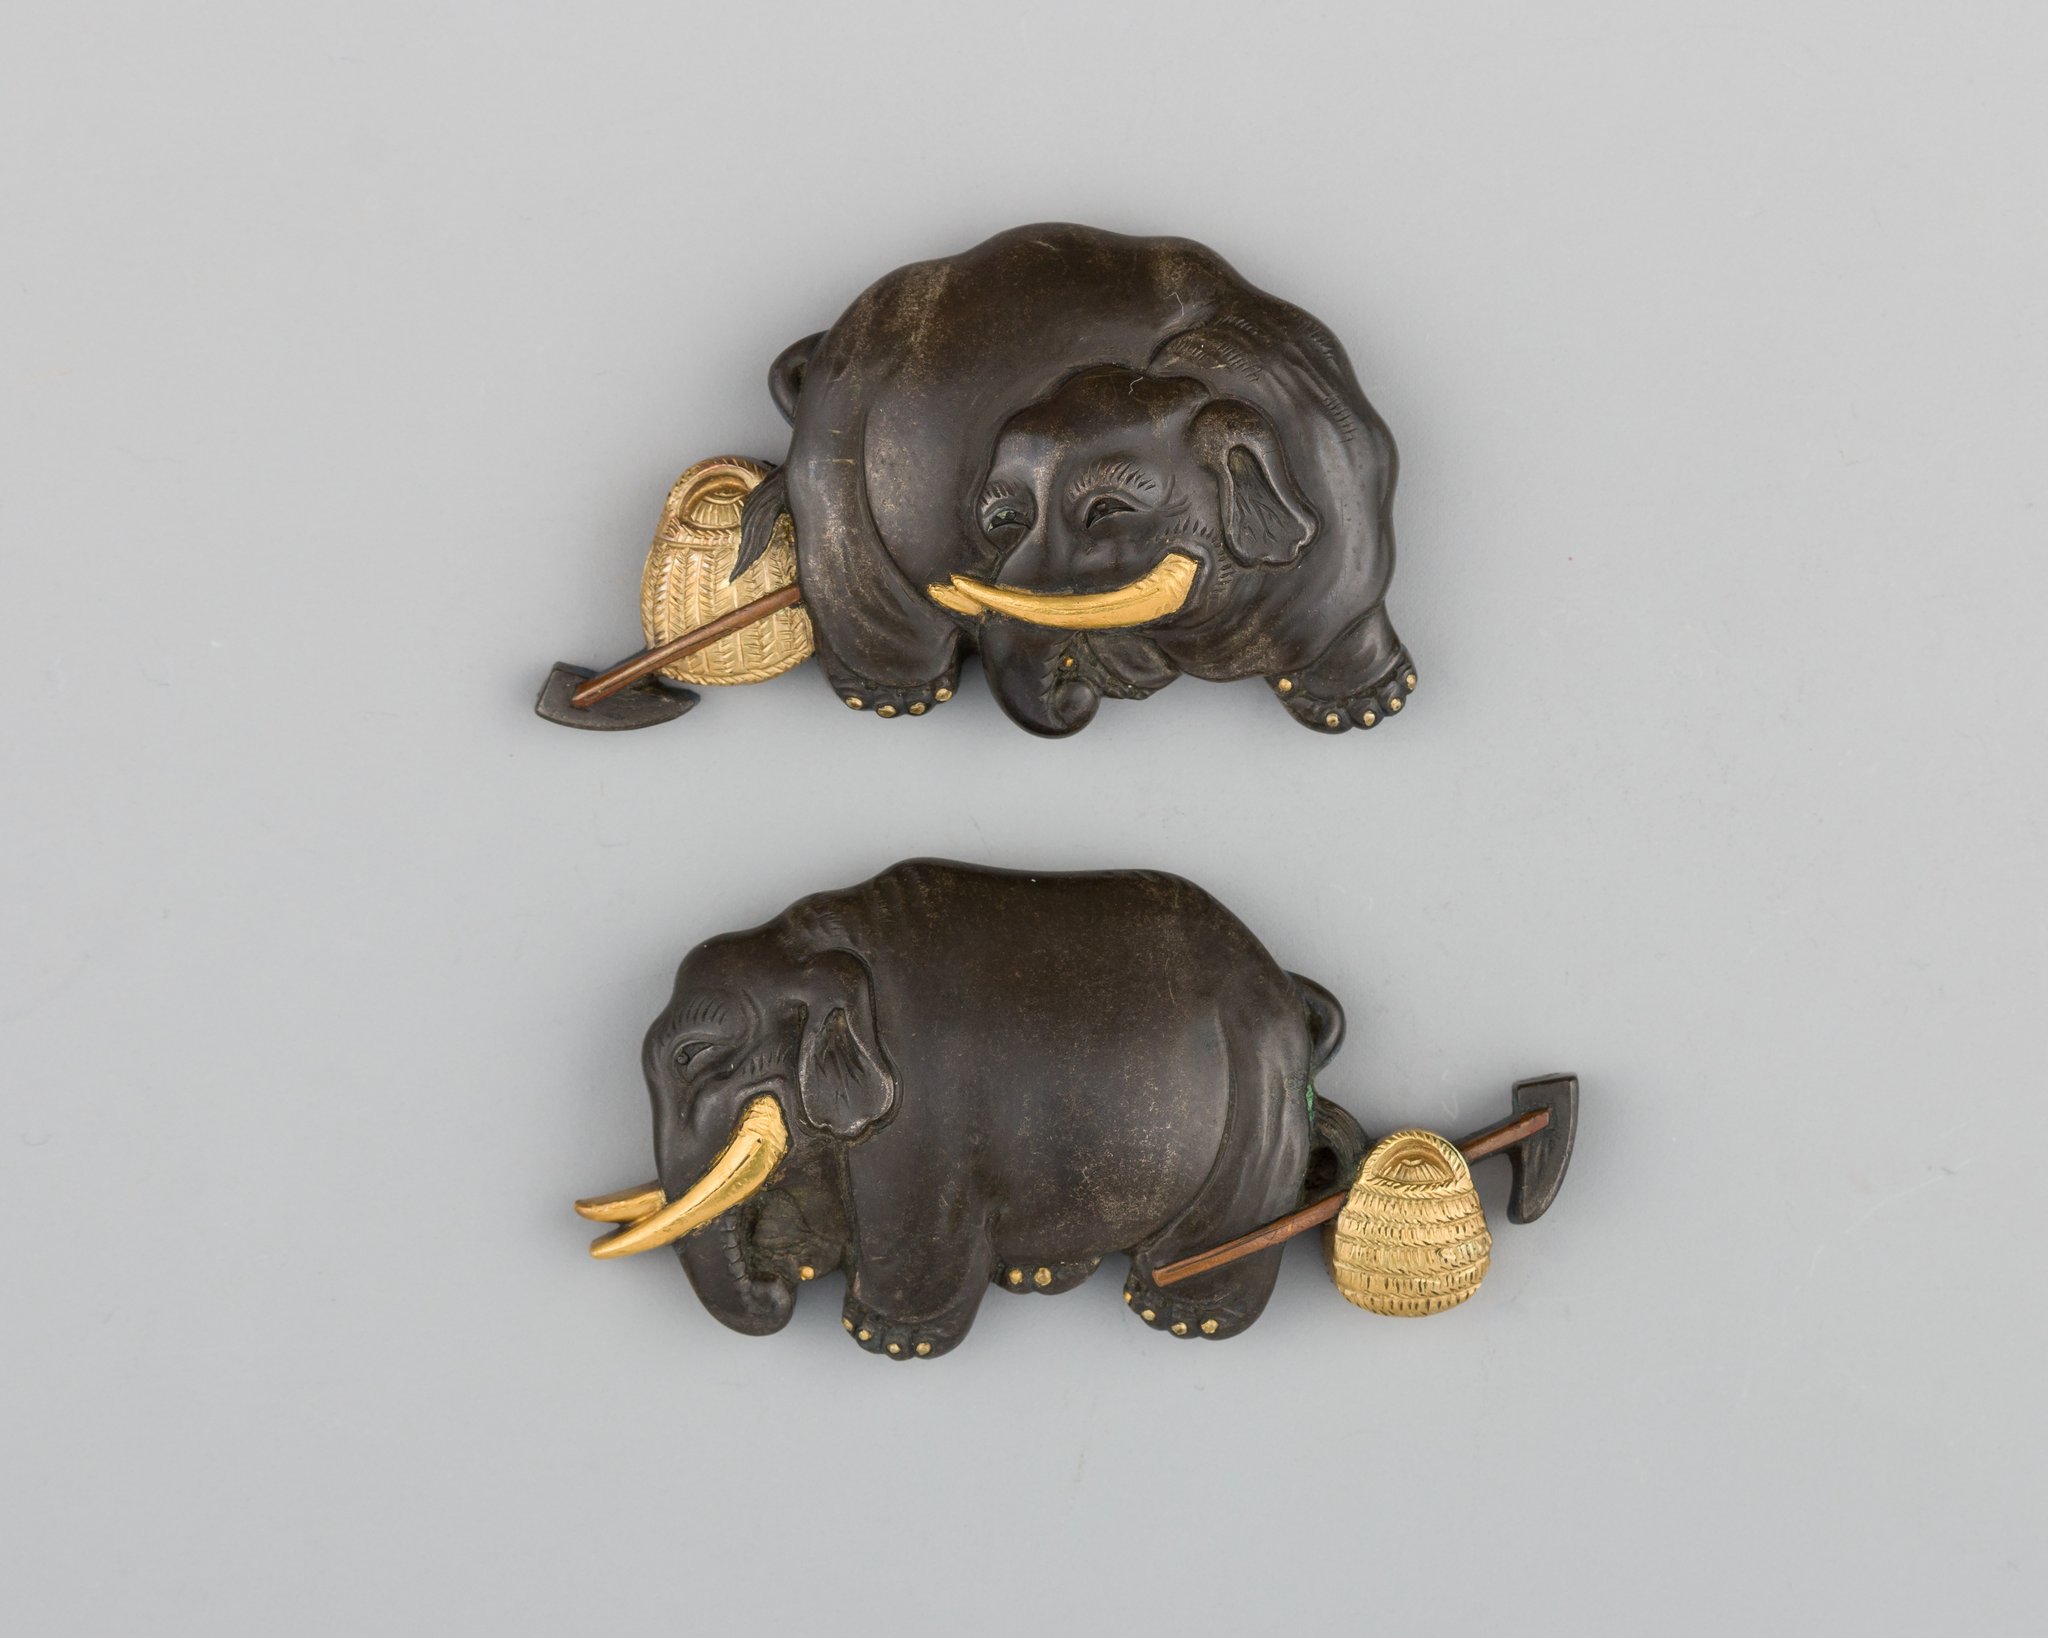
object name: pair of sword grip ornament menuki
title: Pair of Sword-Grip Ornaments (Menuki)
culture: japanese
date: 1743-1801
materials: copper, silver alloy, gold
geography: japan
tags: elephants